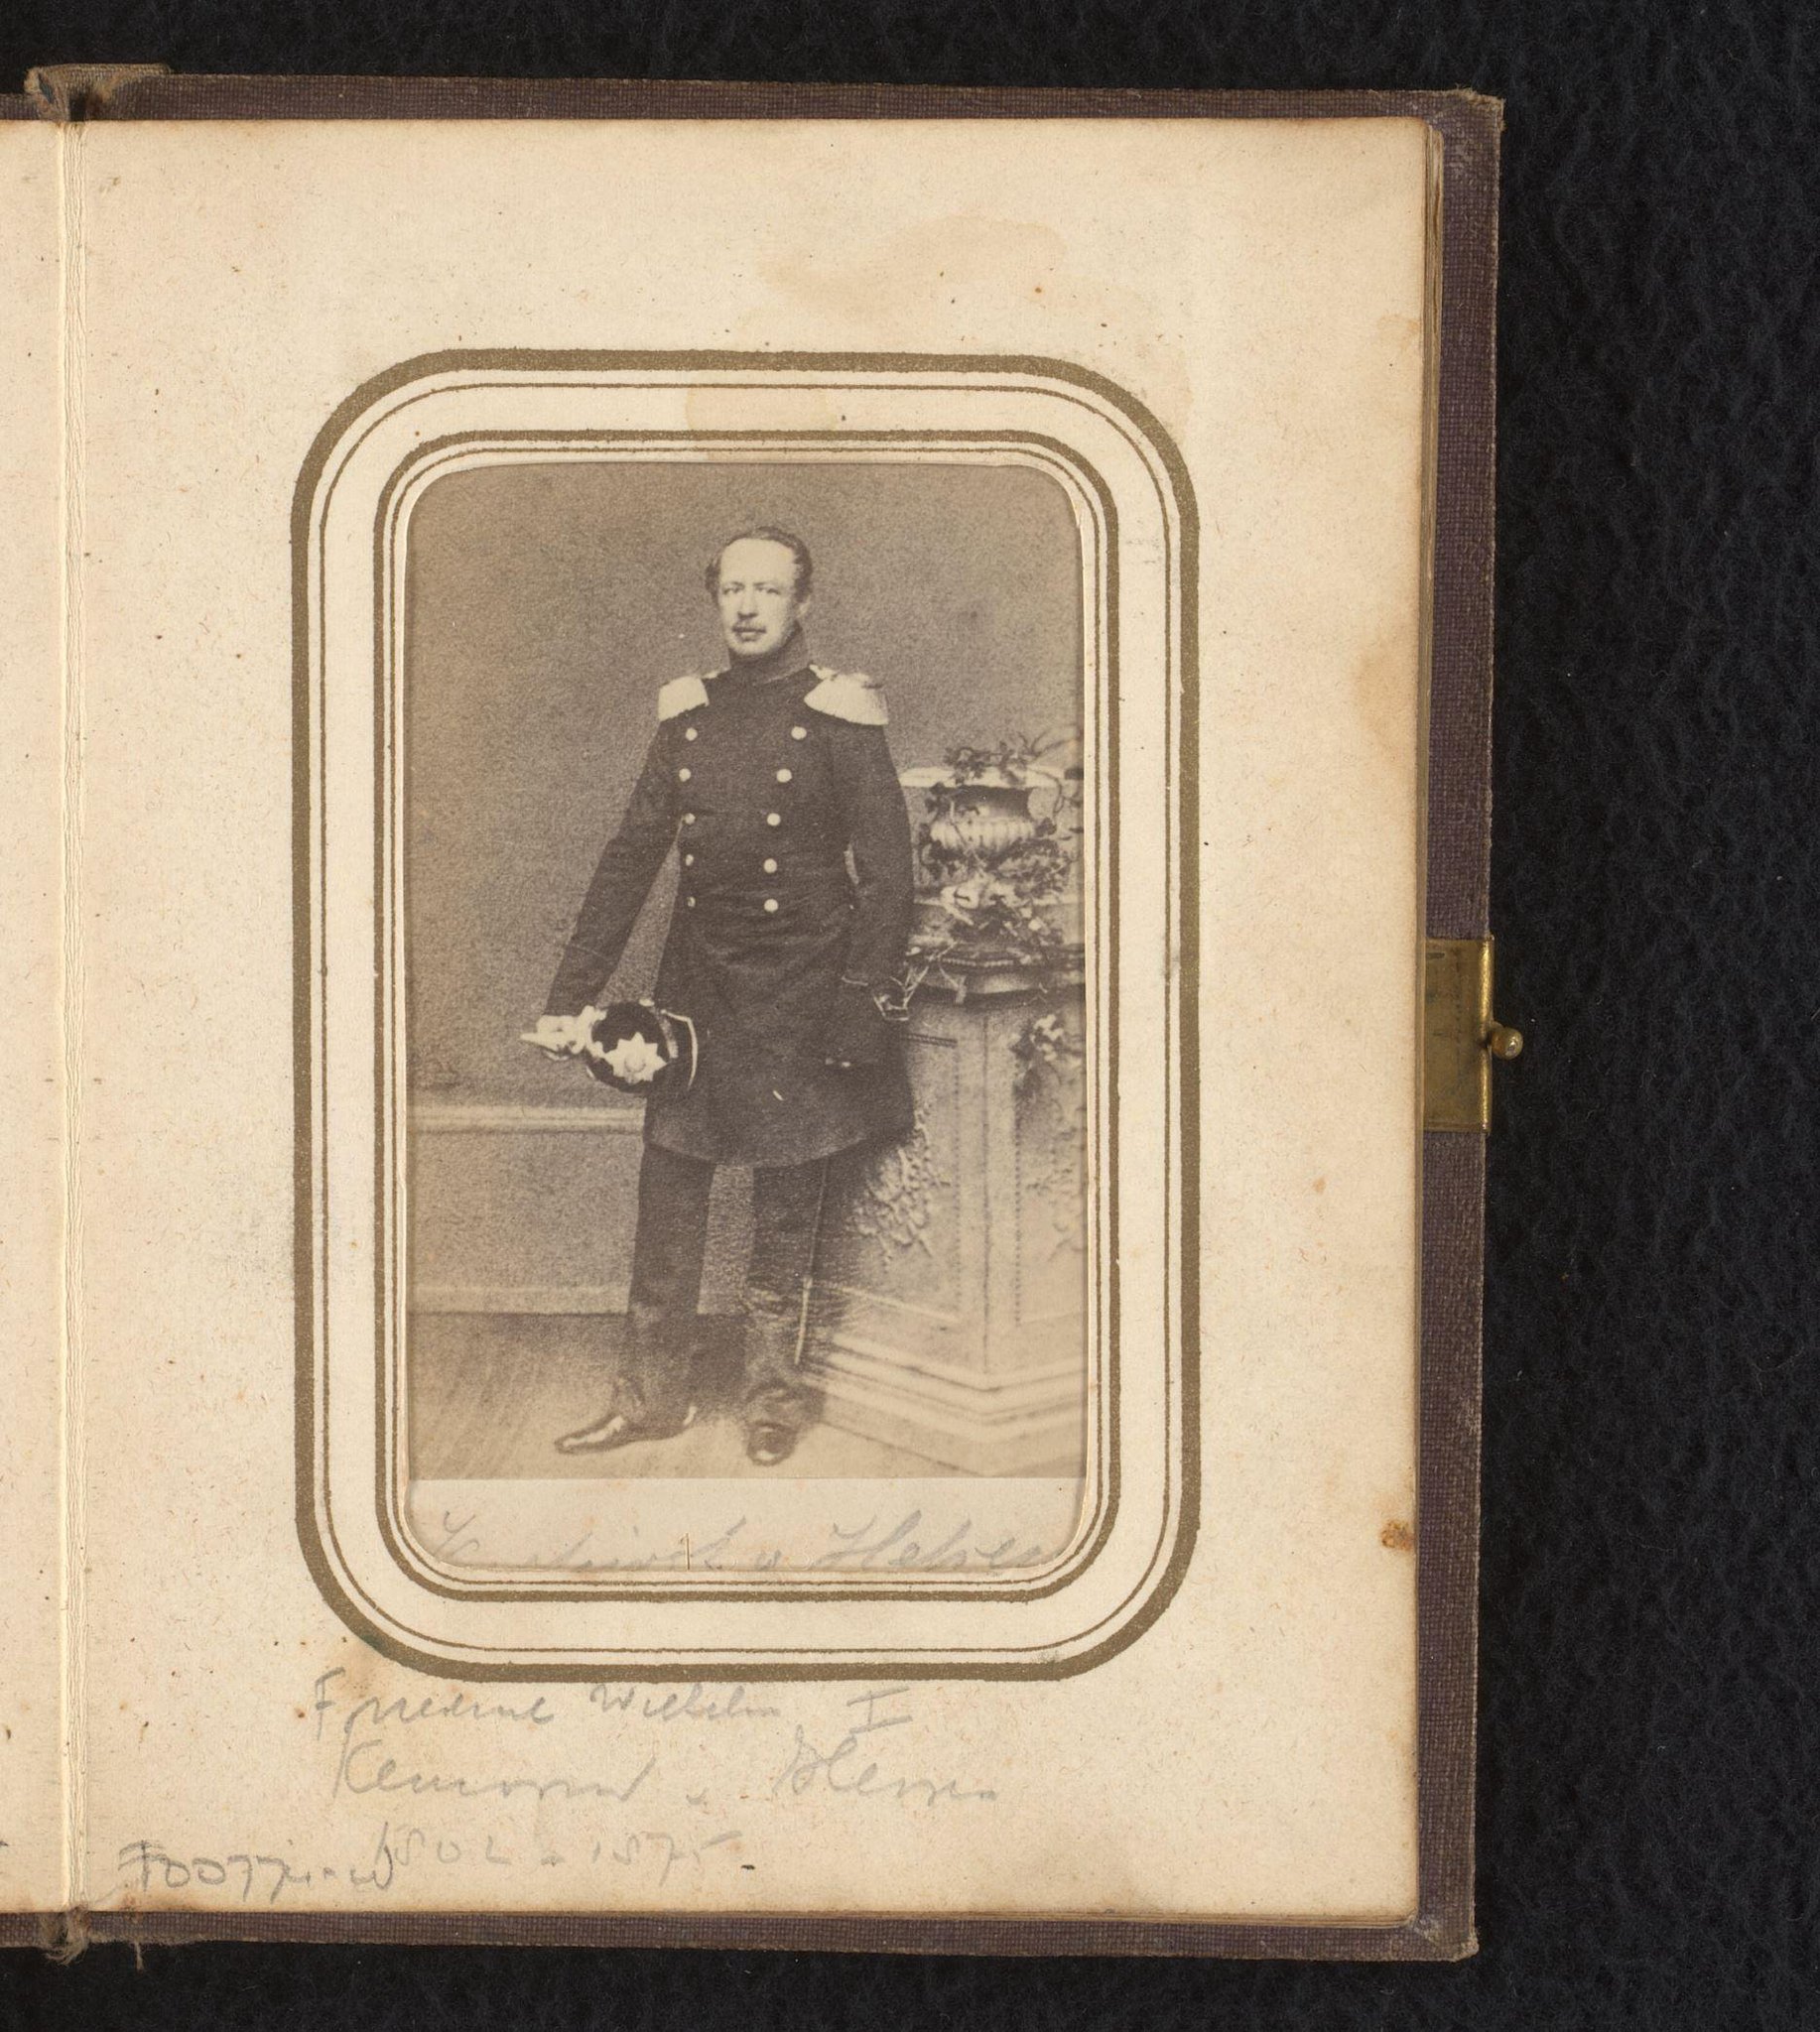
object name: album leaf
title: Portret van Frederik Willem I van Hessen-Kassel in uniform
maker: Anonymous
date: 1850-1875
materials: cardboard, photographic support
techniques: albumen print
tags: prague, aristocracy; 'aristocratia' (ripa), historical persons, (military) uniforms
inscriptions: annotation: ‘Friedrich Wilhelm I/ keurvorst v Hessen/ 1802-1875’, number: ‘1353.’, number: ‘1353’, annotation: ‘keurfurst v Hessen’